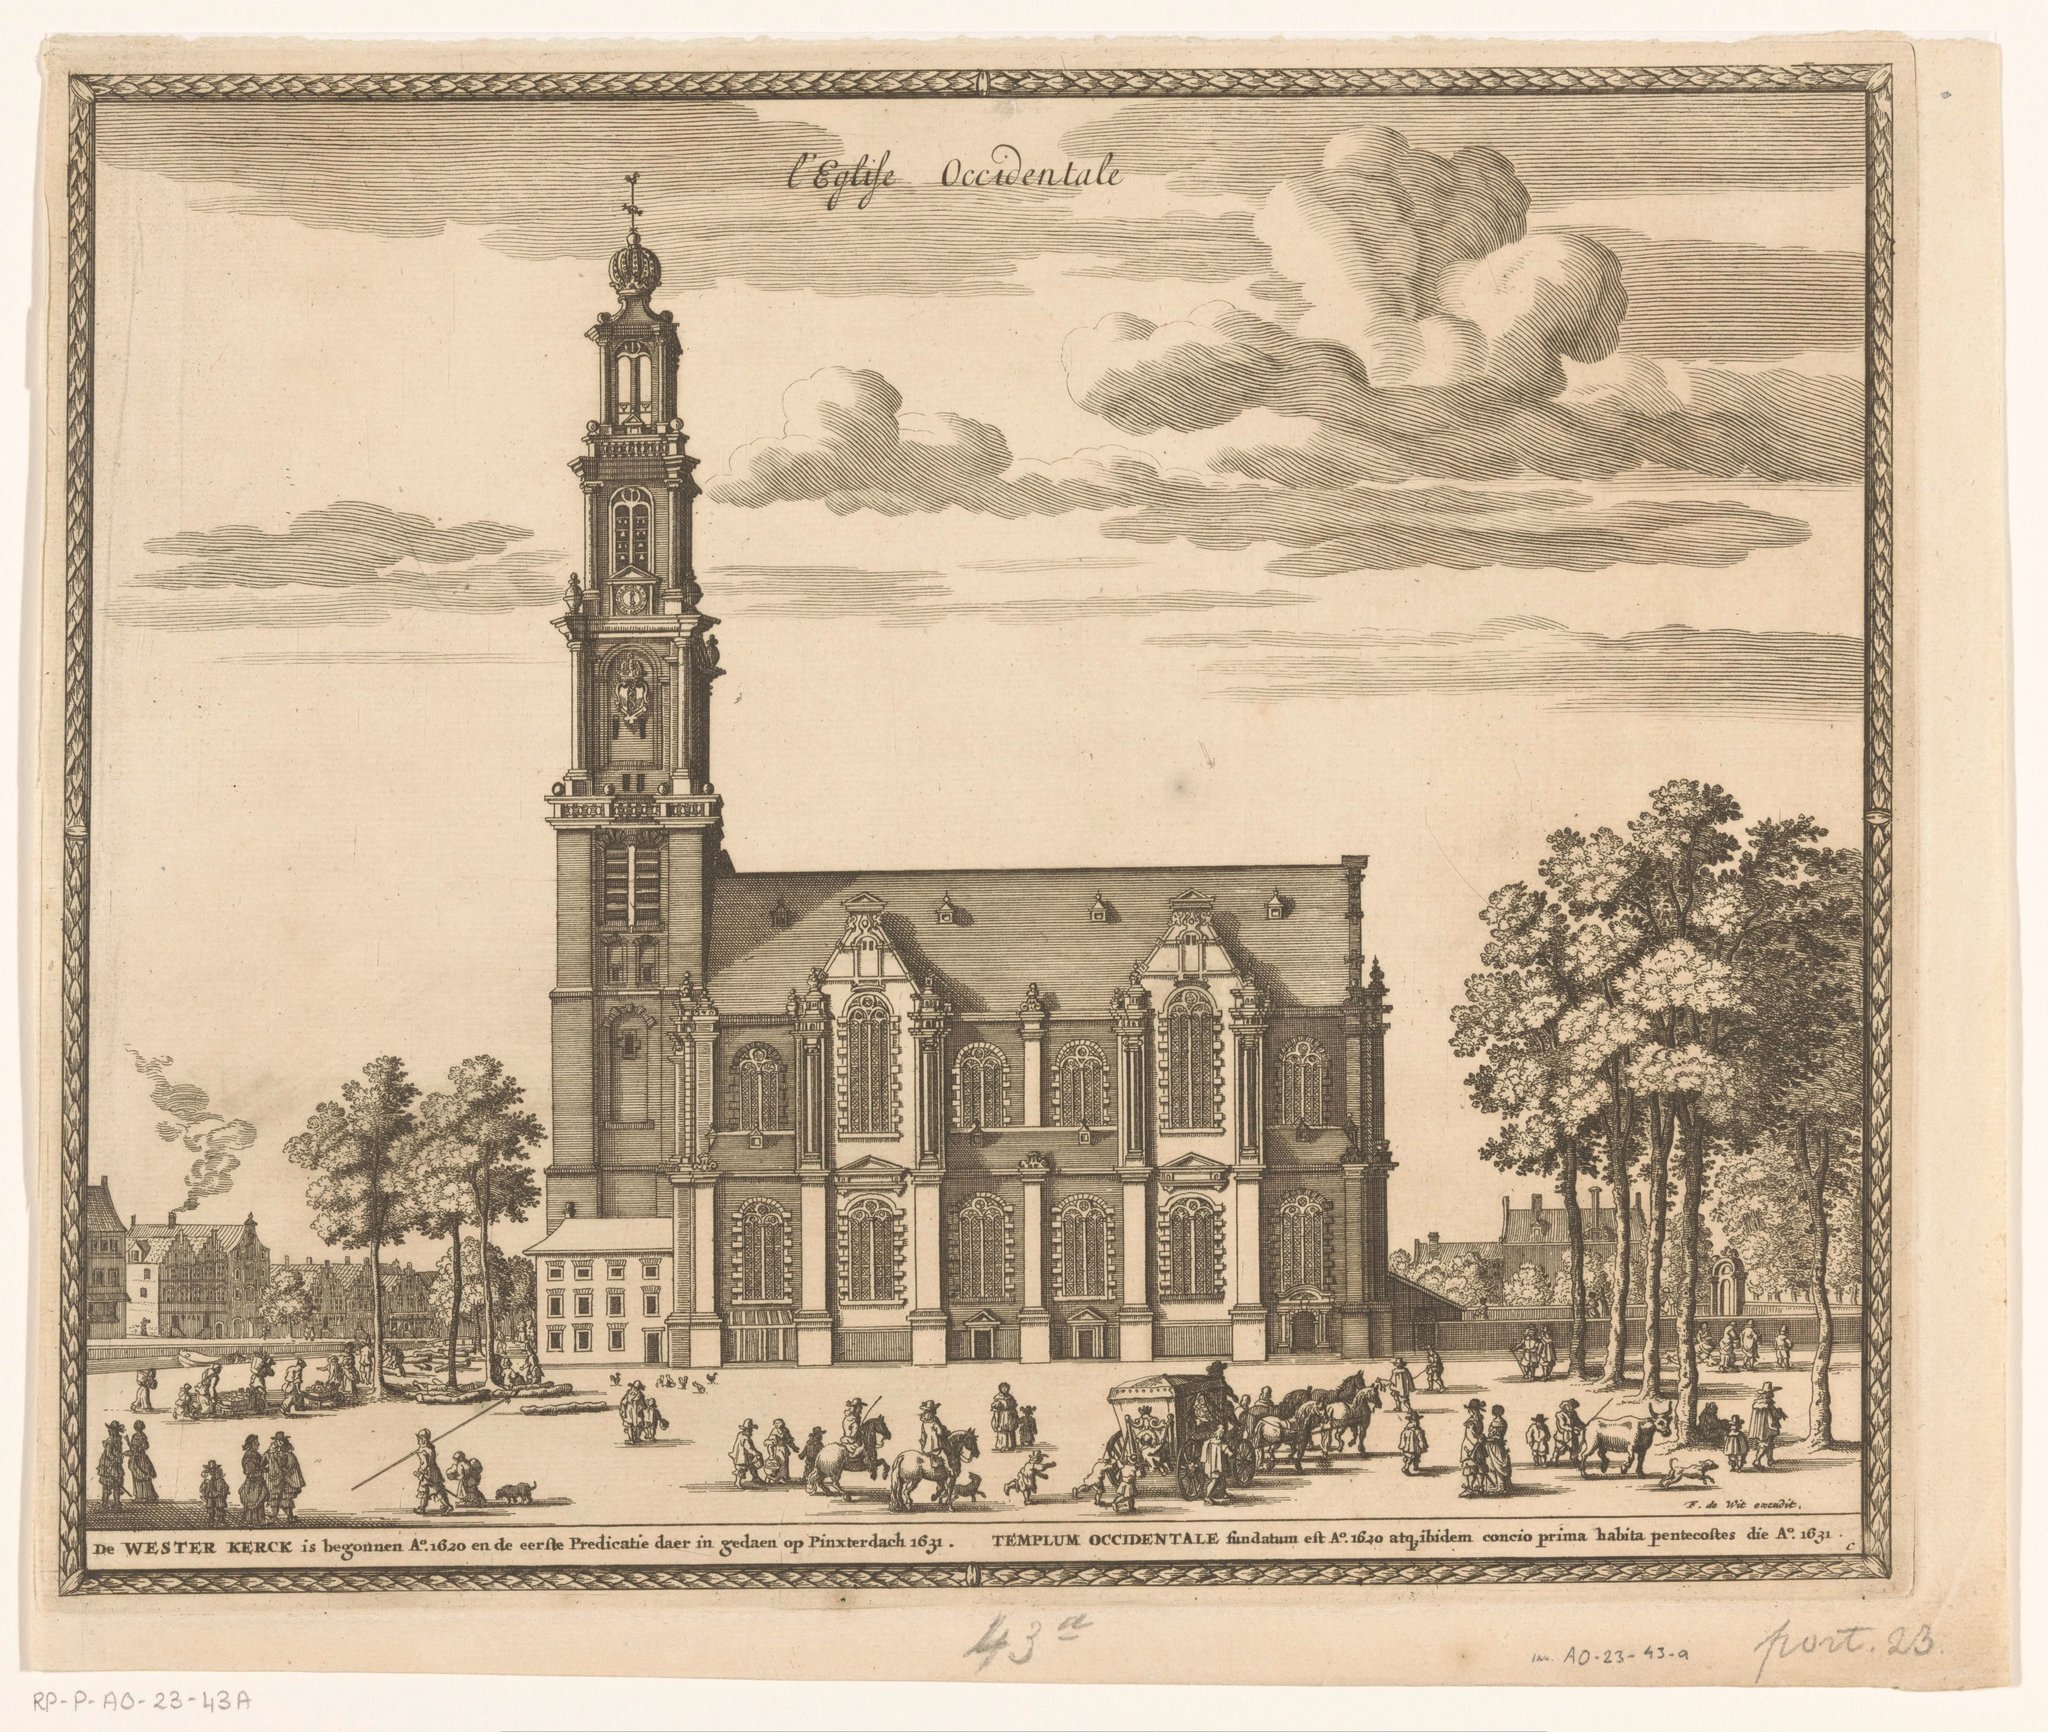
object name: print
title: Gezicht op de Westerkerk te Amsterdam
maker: Anonymous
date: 1662-1728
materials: paper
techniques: engraving, etching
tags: church (exterior), street (+ city(-scape) with figures, staffage)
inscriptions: collector's mark: Lugt 2228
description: Prent ook gebruikt in: La celebre ville d'Amsterdam, representée dans toute sa splendeur et sa magnificence (...) / De heerlykheid der wyd-vermaerde stad Amsterdam (…). Leiden: Pieter van der Aa, s.a. En in: Aa, Pieter van der. Europa. Leiden: Pieter van der Aa, s.a. [ca. 1715]. En in: Aa, Pieter van der. La galerie agreable du monde (...). 66 delen. Leiden: Pieter van der Aa, 1728, dl. 17. Zie ook RP-P-AO-23-43.